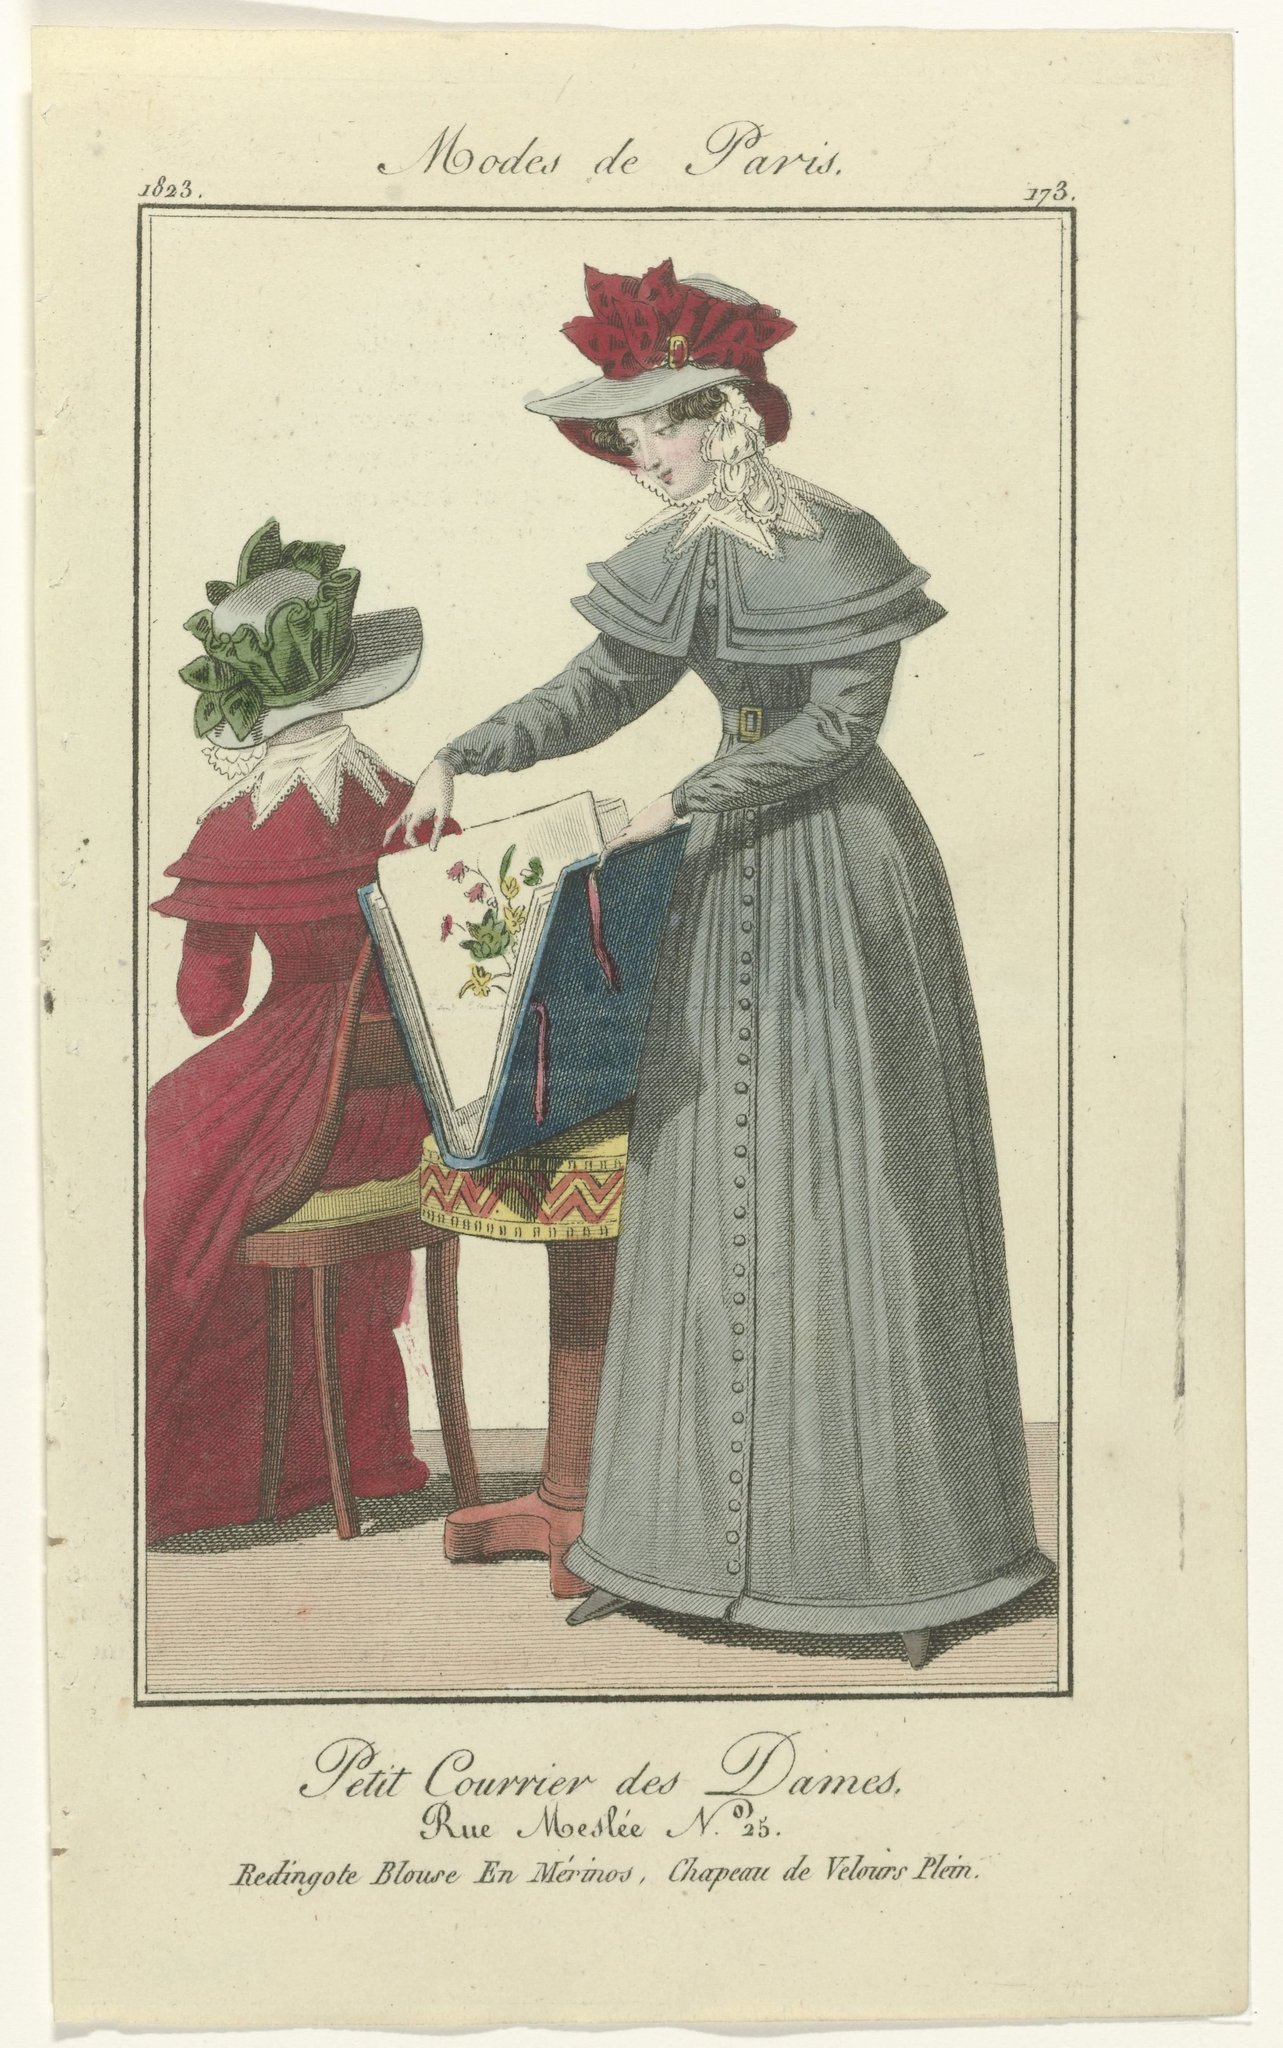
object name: fashion print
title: Petit Courrier des Dames, 1823, No. 173 : Redingote Blouse en Mérinos (...)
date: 1823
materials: paper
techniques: engraving, hand coloring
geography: paris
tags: dress, gown: redingote (+ women's clothes), print, e.g.: engraving, etching, lithograph, fashion plates, head-gear: hat (+ women's clothes), belt, girdle, waistband (+ women's clothes)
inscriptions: caption: ‘Redingote Blouse En Mérinos, Chapeau de Velours Plein.’, title: ‘Modes de Paris.’, title: ‘Petit Courrier des Dames.’, address: ‘Rue Meslée No. 25’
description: Vrouw in een 'redingote blouse' van merinowol met dubbele schouderkraag, ceintuur met vierkante gesp en middenvoor een rij knopen. Hoed van effen fluweel. Zij bekijkt losse prenten of tekeningen in een map. Naast haar een zittende vrouw, op de rug gezien, gekleed in eenzelfde japon. Prent uit het modetijdschrift Petit Courrier des Dames (1821-1868).